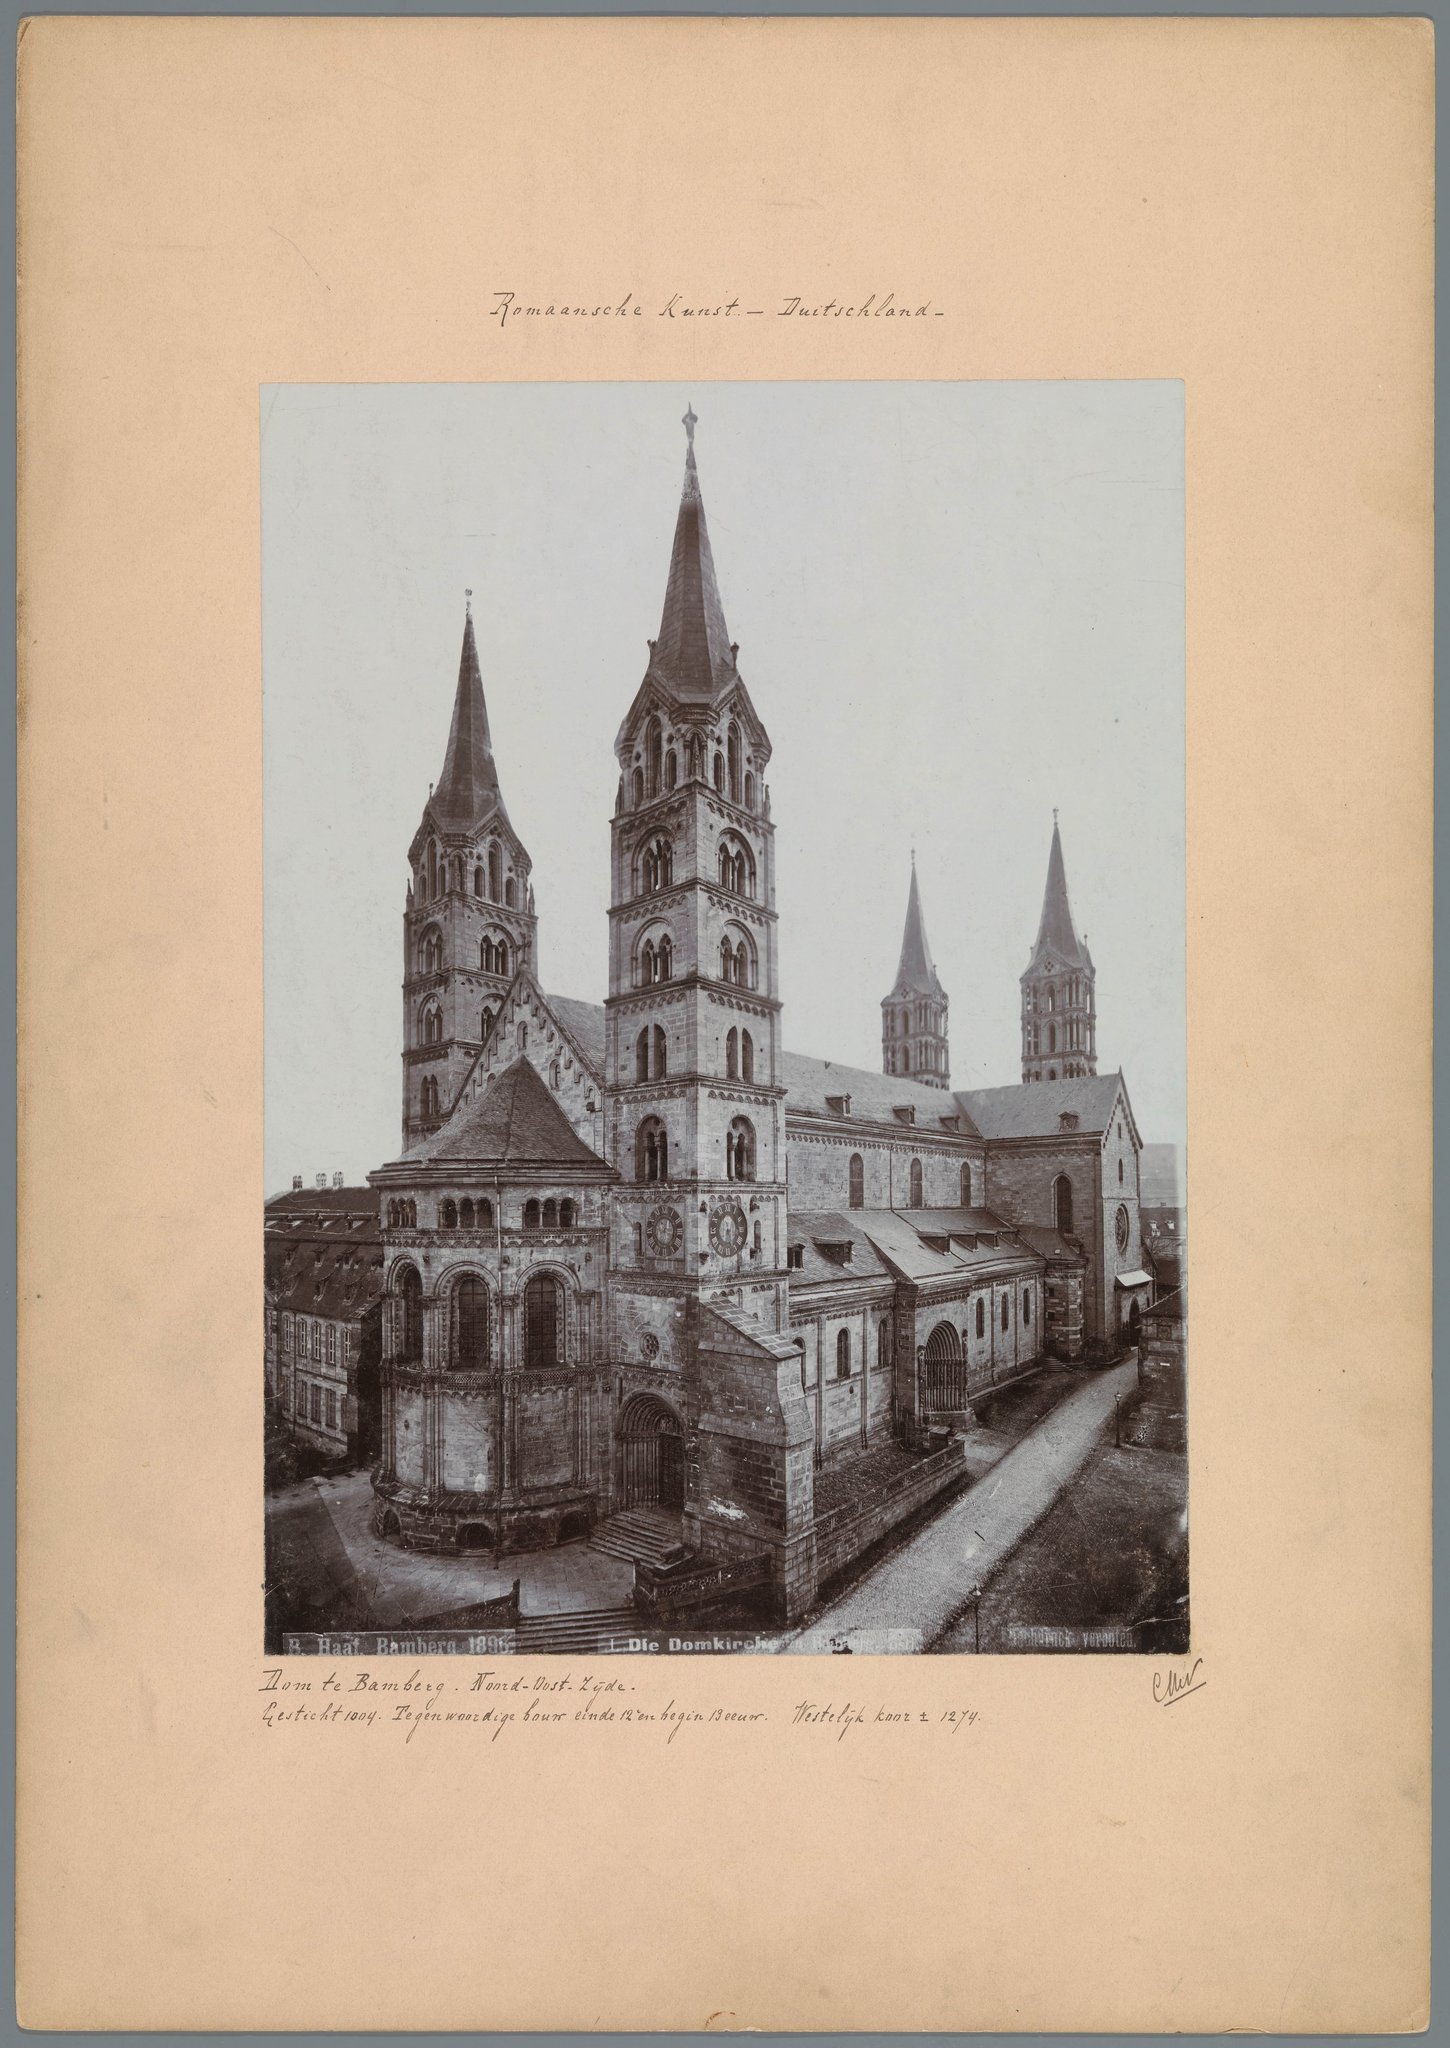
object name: photograph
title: Die Domkirche in Bamberg. ostl.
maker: bernhard haaf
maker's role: fotograaf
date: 1896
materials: cardboard, photographic support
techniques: daylight paper print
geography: bamberg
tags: church (exterior), façade (of house or building), parts of church exterior and annexes: tower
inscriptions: inscription: ‘CWN.’, inscription: ‘Romaansche Kunst - Duitschland . Dom te Bamberg (...) Westelijk koor +- 1274.’, annotation, collector's mark: ‘INSTITUUT VOOR KUNST- NIJVERHEIDSONDERWIJS GABRIËL METSUSTRAAT No. 16. AMSTERDAM’, collector's mark: ‘KUNSTNIJVERHEIDSCHOOL QUELLINUS AMSTERDAM FRANS HALSSTRAAT 14.’